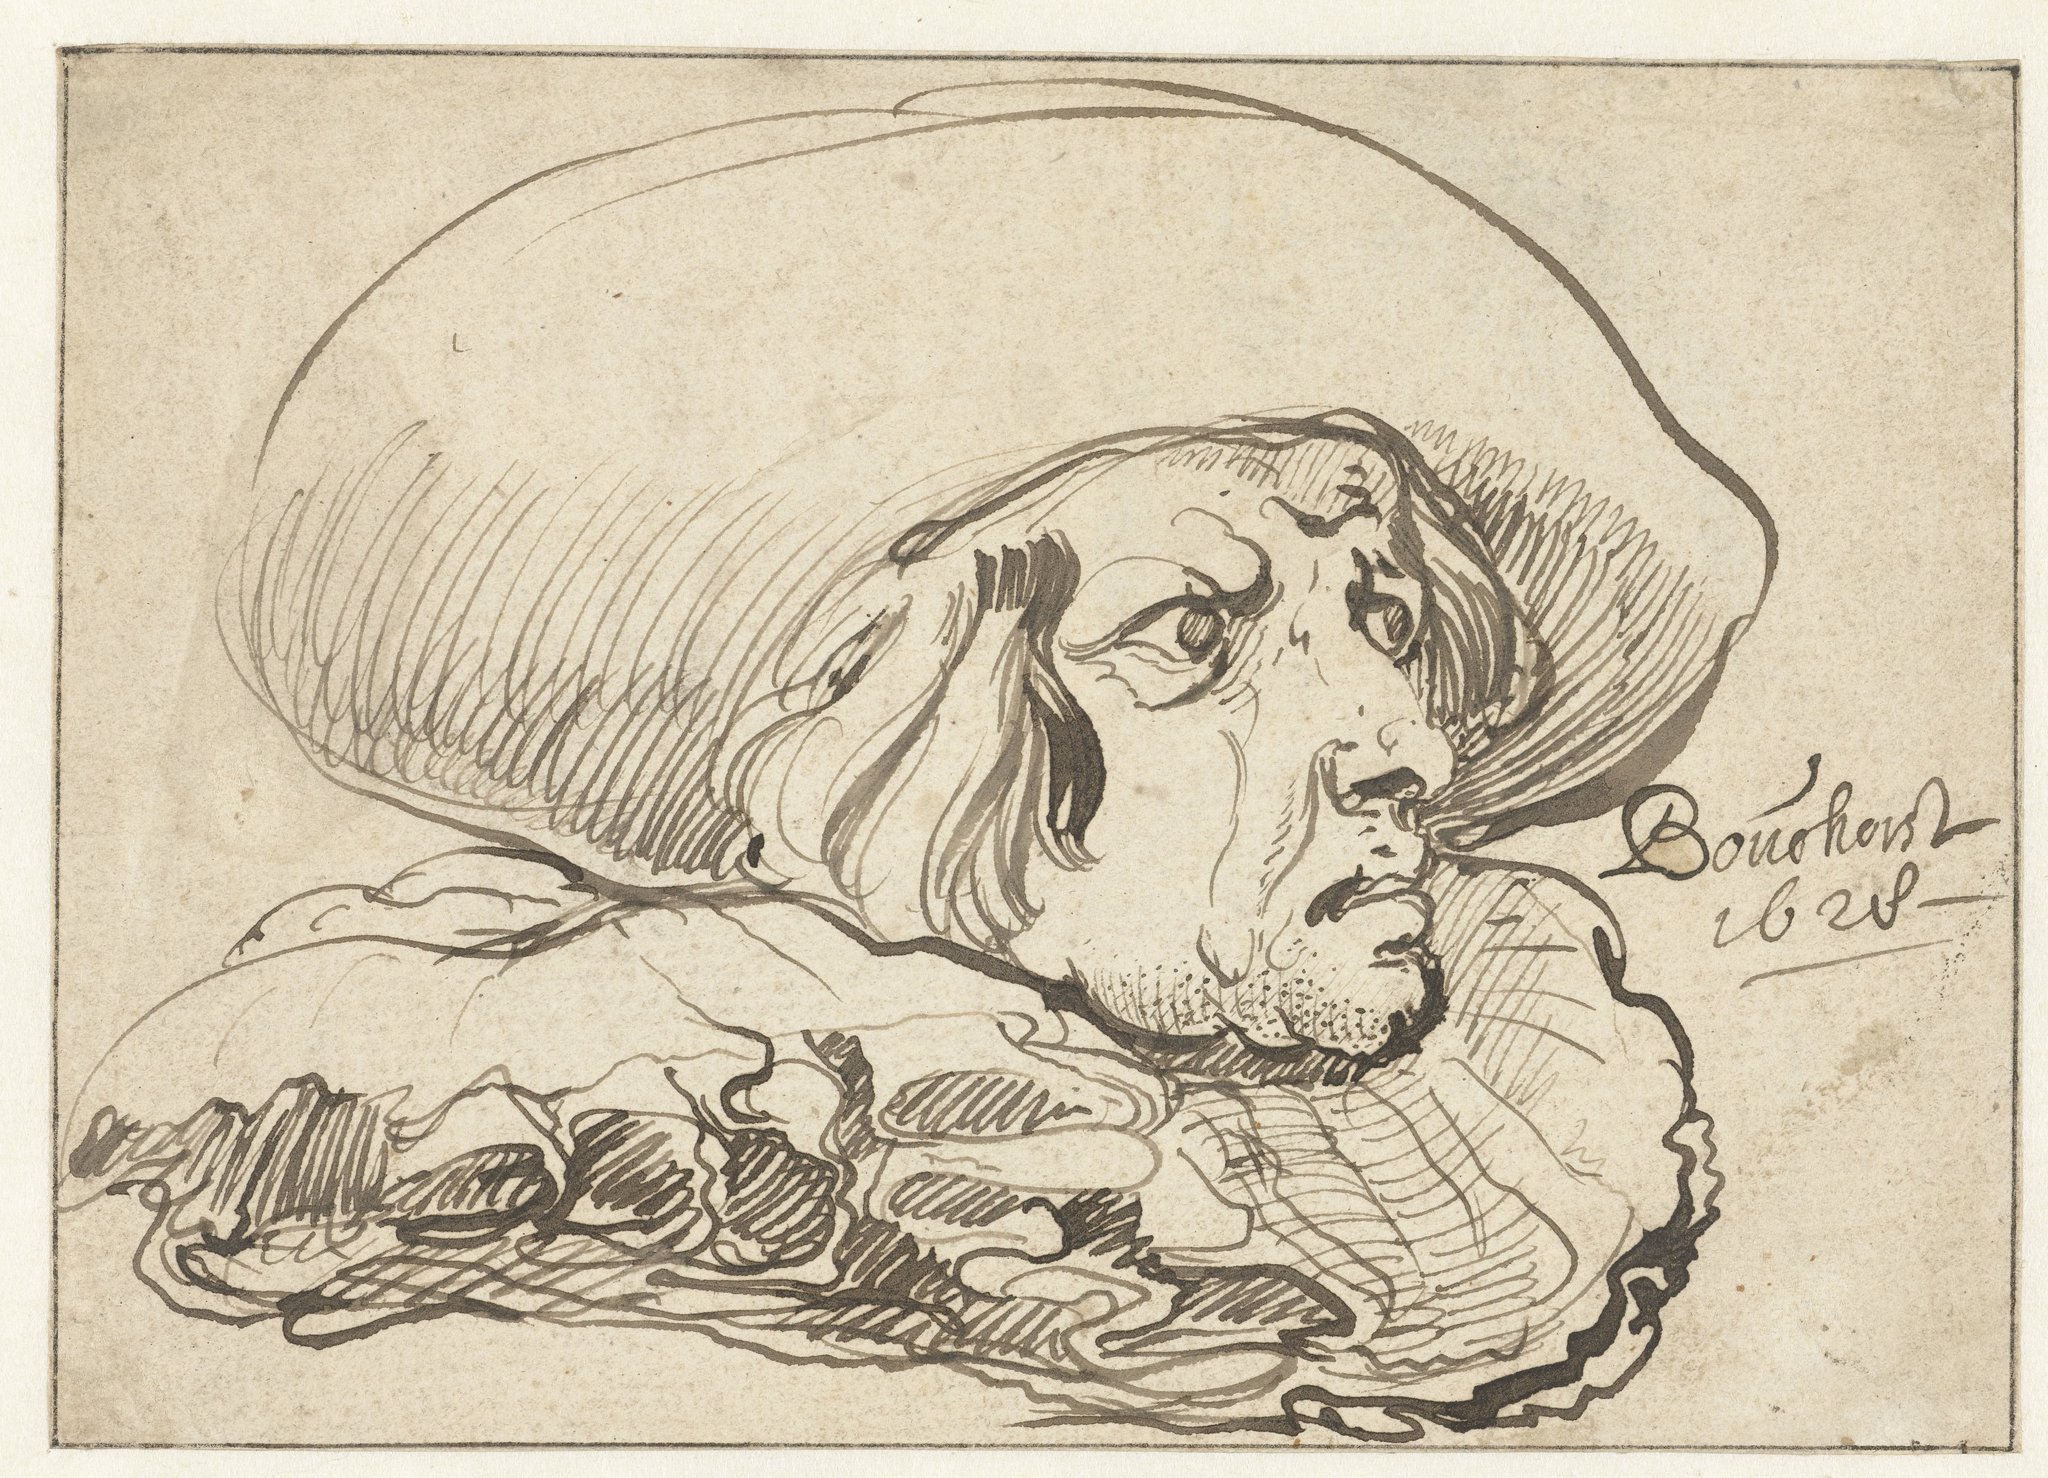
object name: drawing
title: Zelfportret van Jan Philipsz. Bouckhorst met angstige blik in de ogen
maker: jan philipsz. van bouckhorst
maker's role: draughtsman, print maker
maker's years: 1588-1631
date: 1628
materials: paper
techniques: pen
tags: head (human), head-gear: hat, neck-gear: collar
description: Marijn Schapelhouman, Rembrandt en de kunst van het tekenen, Zwolle/Amsterdam 2006, p. 45, kleurafb. 40